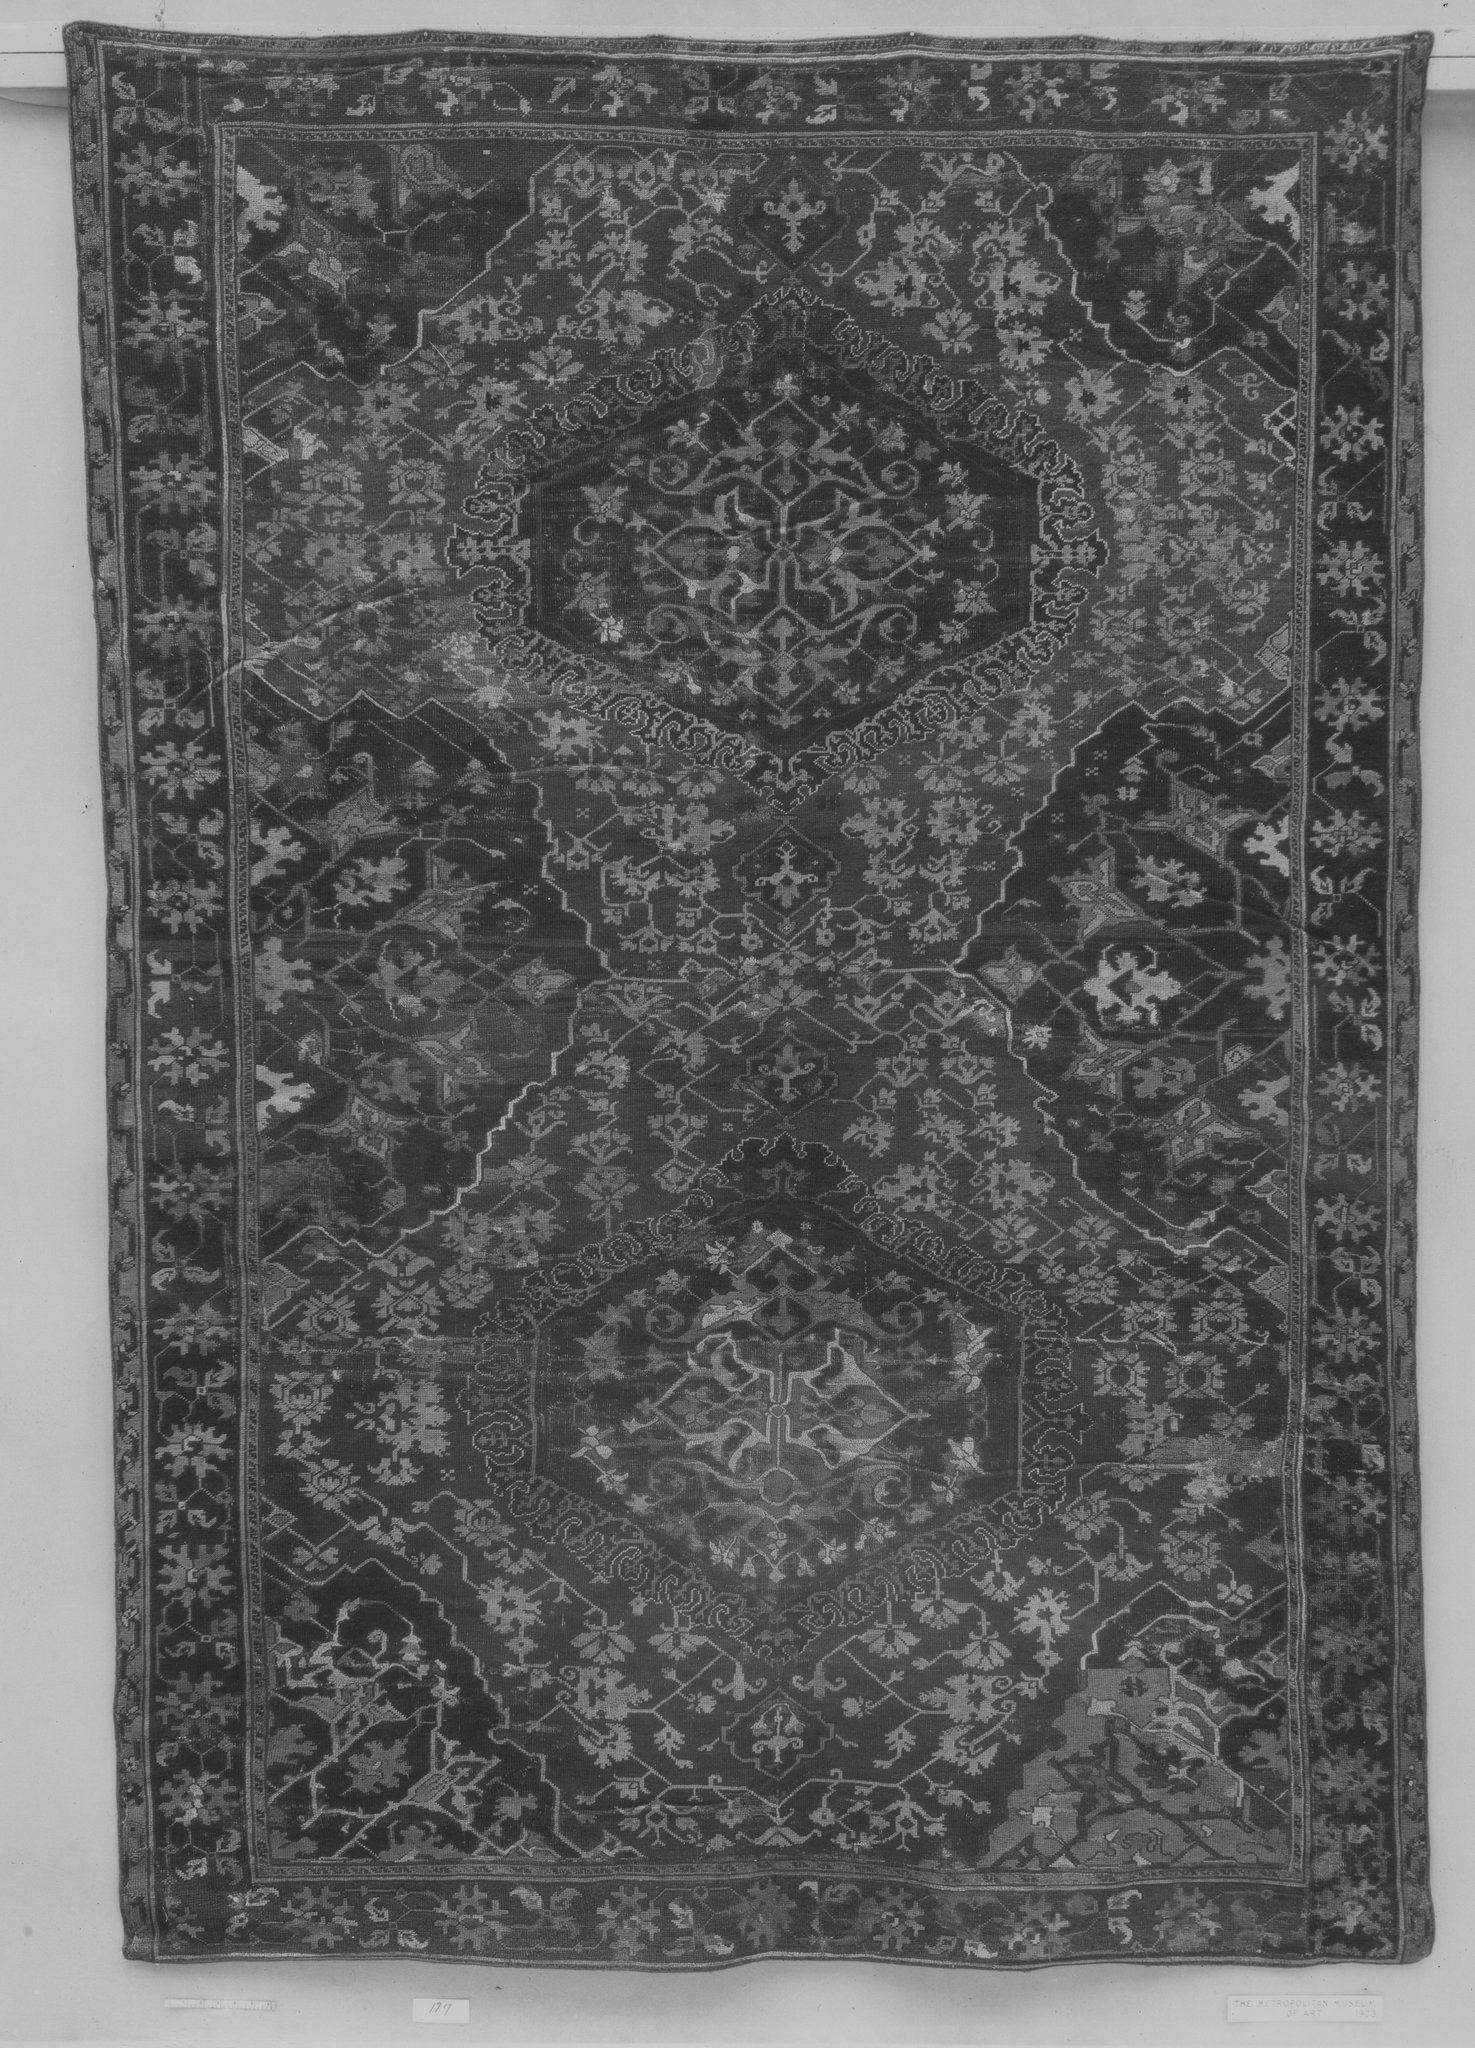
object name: carpet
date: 1701-1800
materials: wool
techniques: pile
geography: turkey